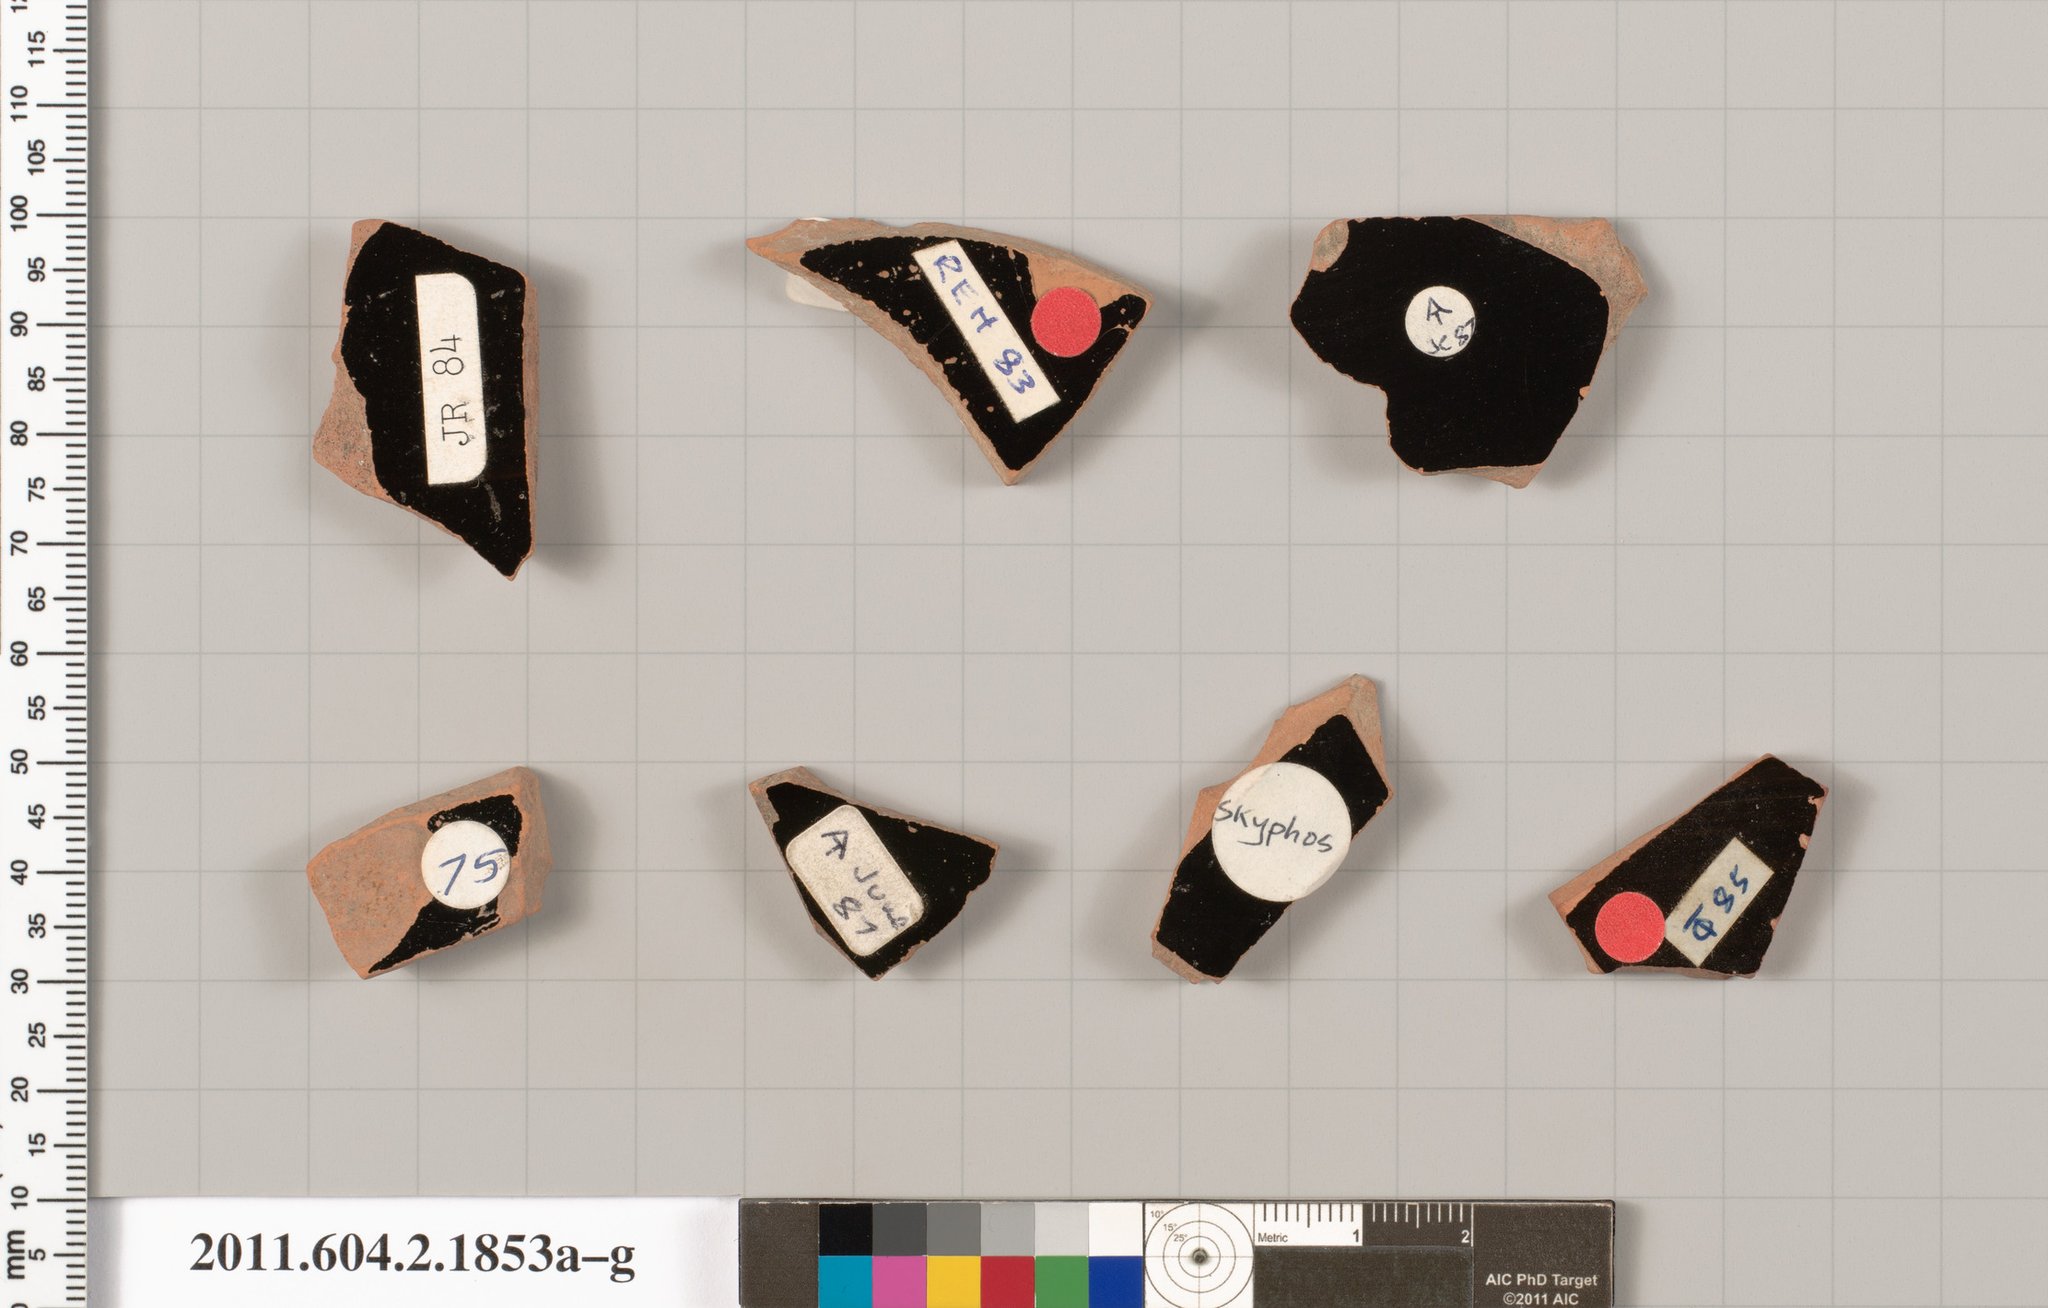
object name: skyphos fragment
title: Terracotta fragments of skyphoi (deep drinking cups)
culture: greek, attic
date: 450-426 BCE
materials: terracotta